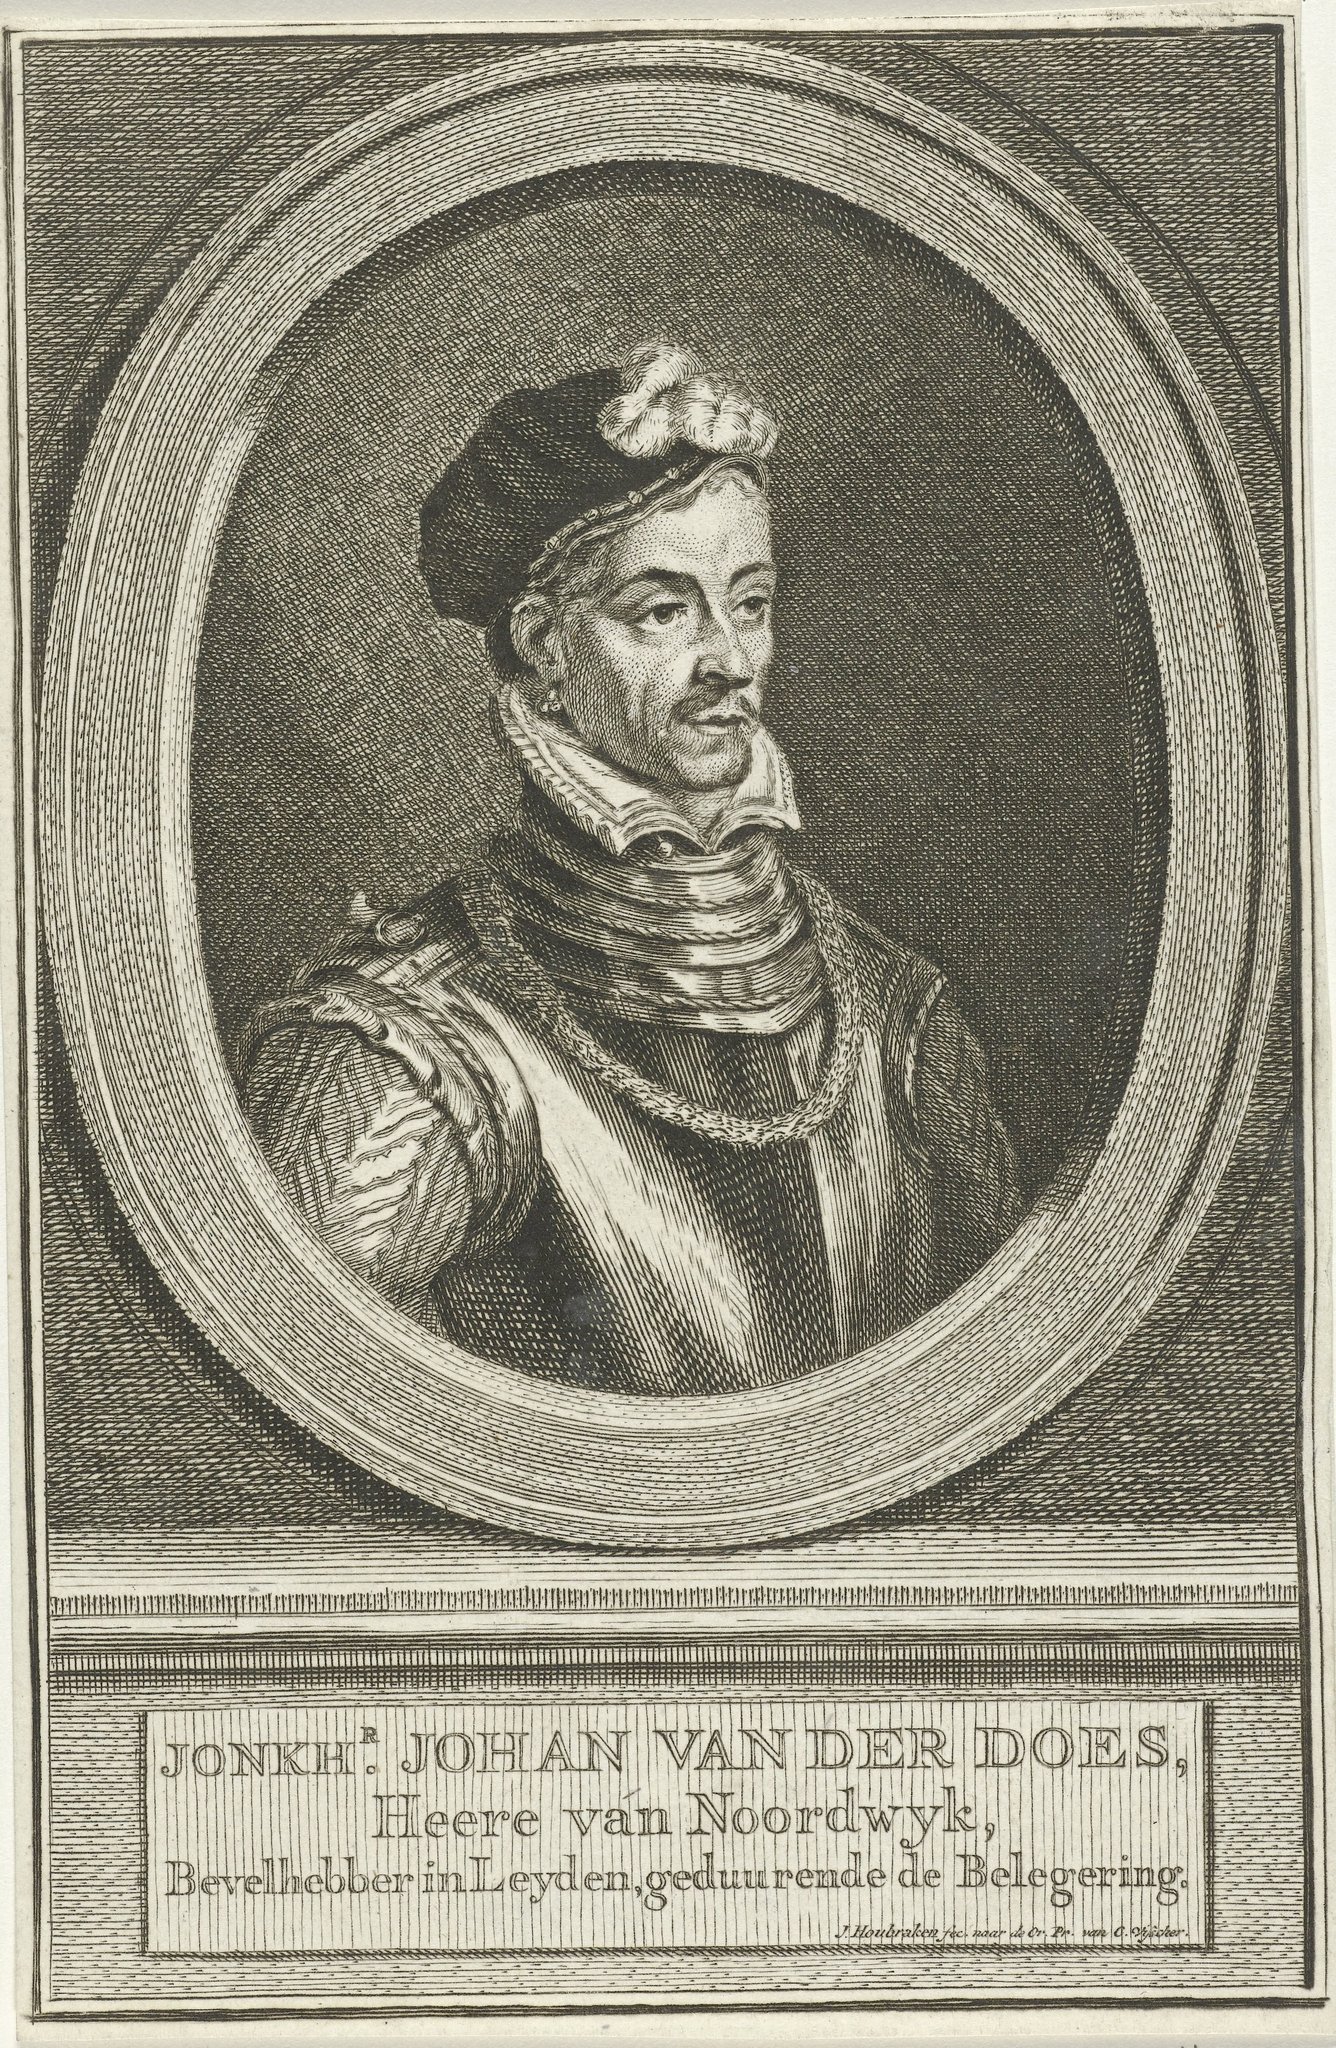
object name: print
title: Jonkhr. Johan van der Does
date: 1790-1796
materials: paper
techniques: engraving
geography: amsterdam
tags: bevelhebber, dichter, filoloog, bibliothecaris, bestuurder, jan van der does (heer van noordwijk en kattendijke)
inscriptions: collector's mark: Lugt 2228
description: Prent oorspronkelijk gebruikt in: Jan Wagenaar, Vaderlandsche historie, vervattende de geschiedenissen der nu Vereenigde Nederlanden, inzonderheid die van Holland (...), 21 delen. Amsterdam, Isaak Tirion, 1749-59. Maar hier naam uitgever verwijderd, waarschijnlijk gebruikt in latere editie. Zie Van Someren 8d.